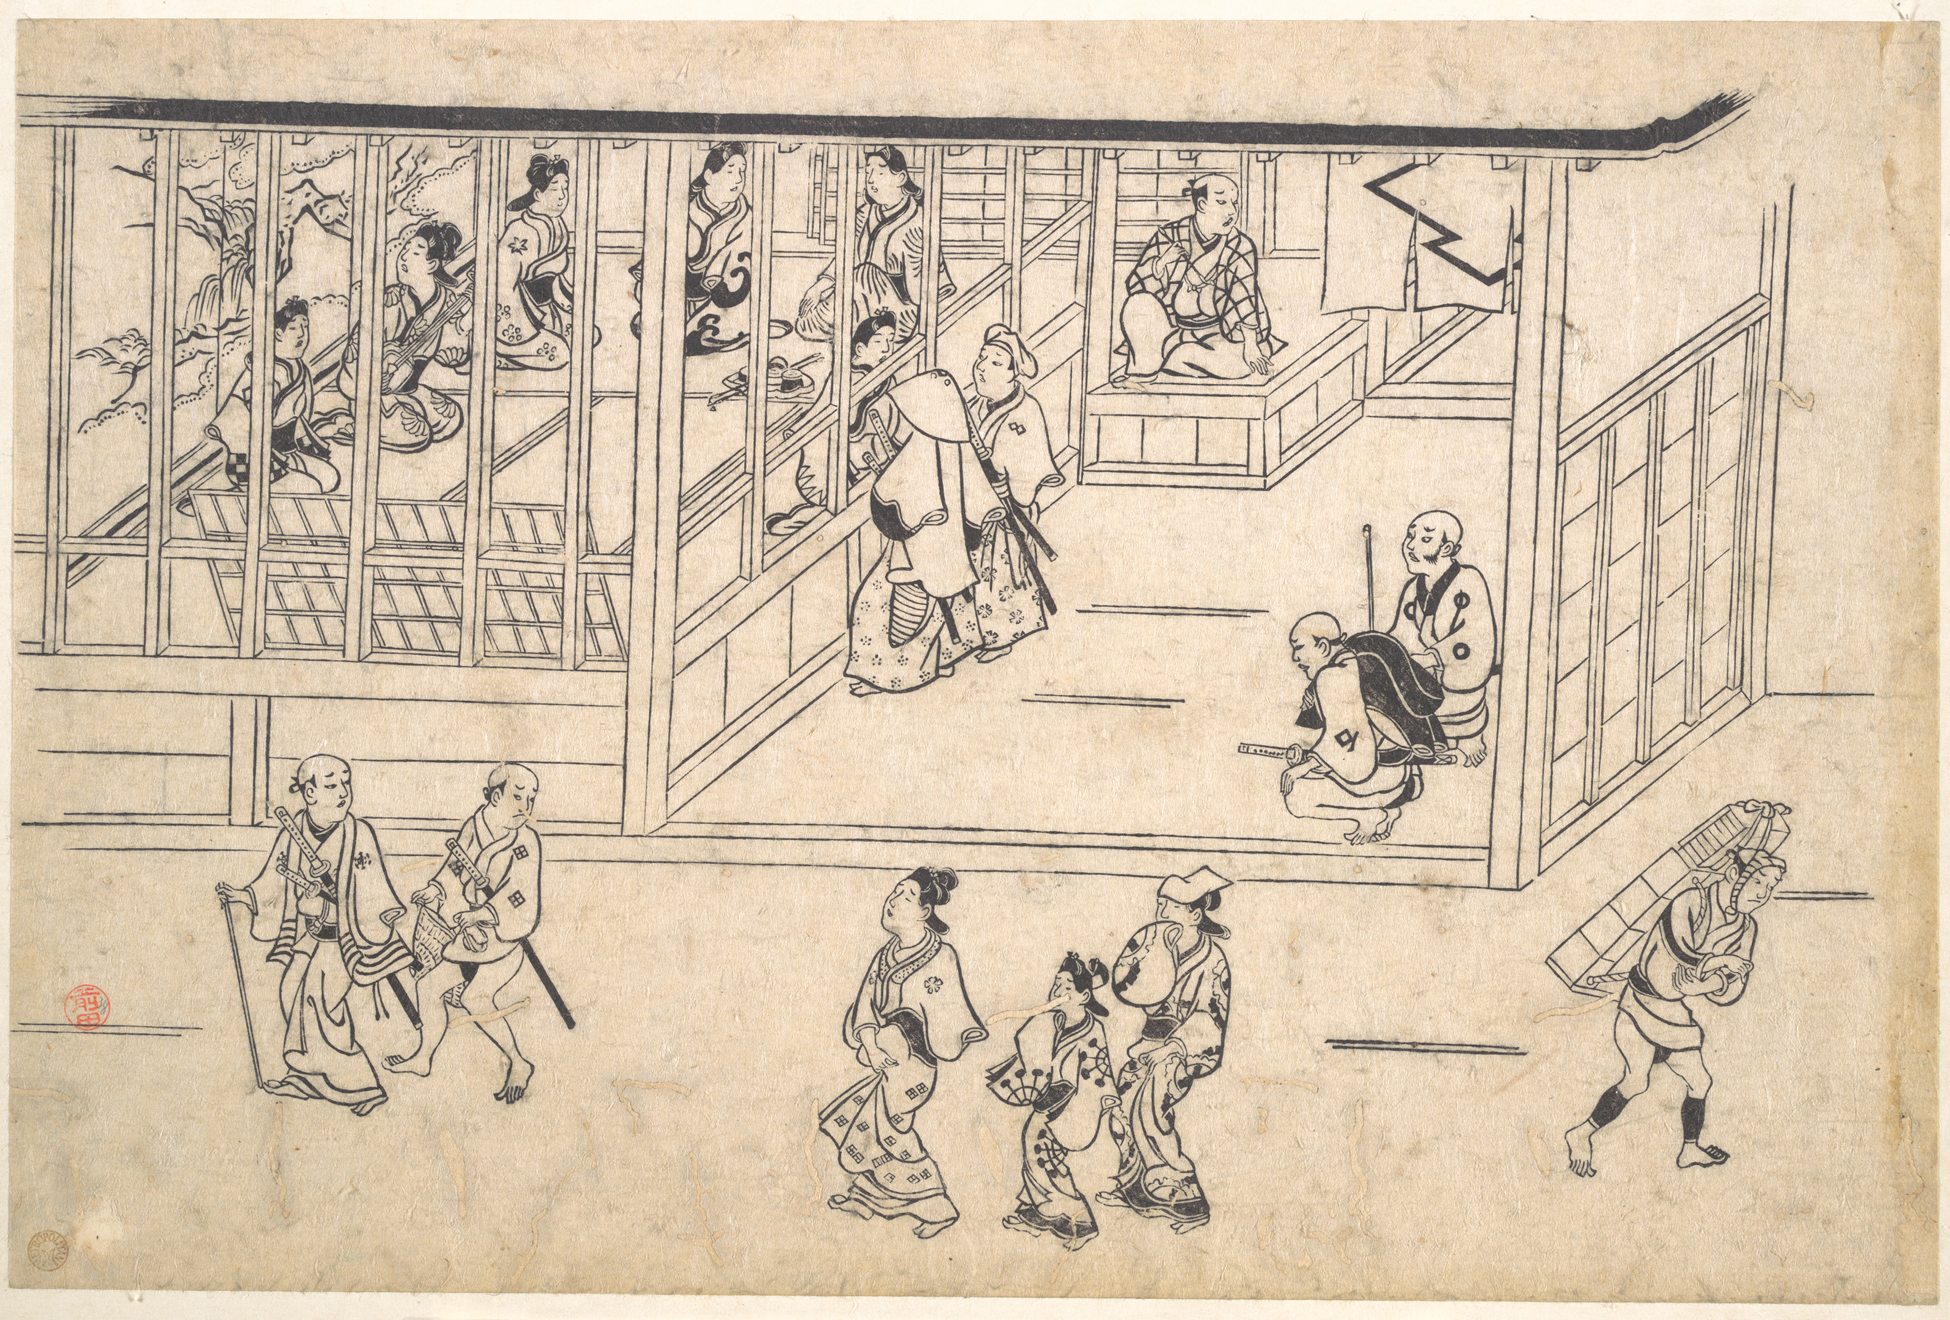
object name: print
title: Street scene in the Yoshiwara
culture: japanese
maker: hishikawa moronobu 菱川師宣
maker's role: artist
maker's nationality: japanese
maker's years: 1618-1694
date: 1680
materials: ink, paper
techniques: woodblock print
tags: houses,streets,men,women